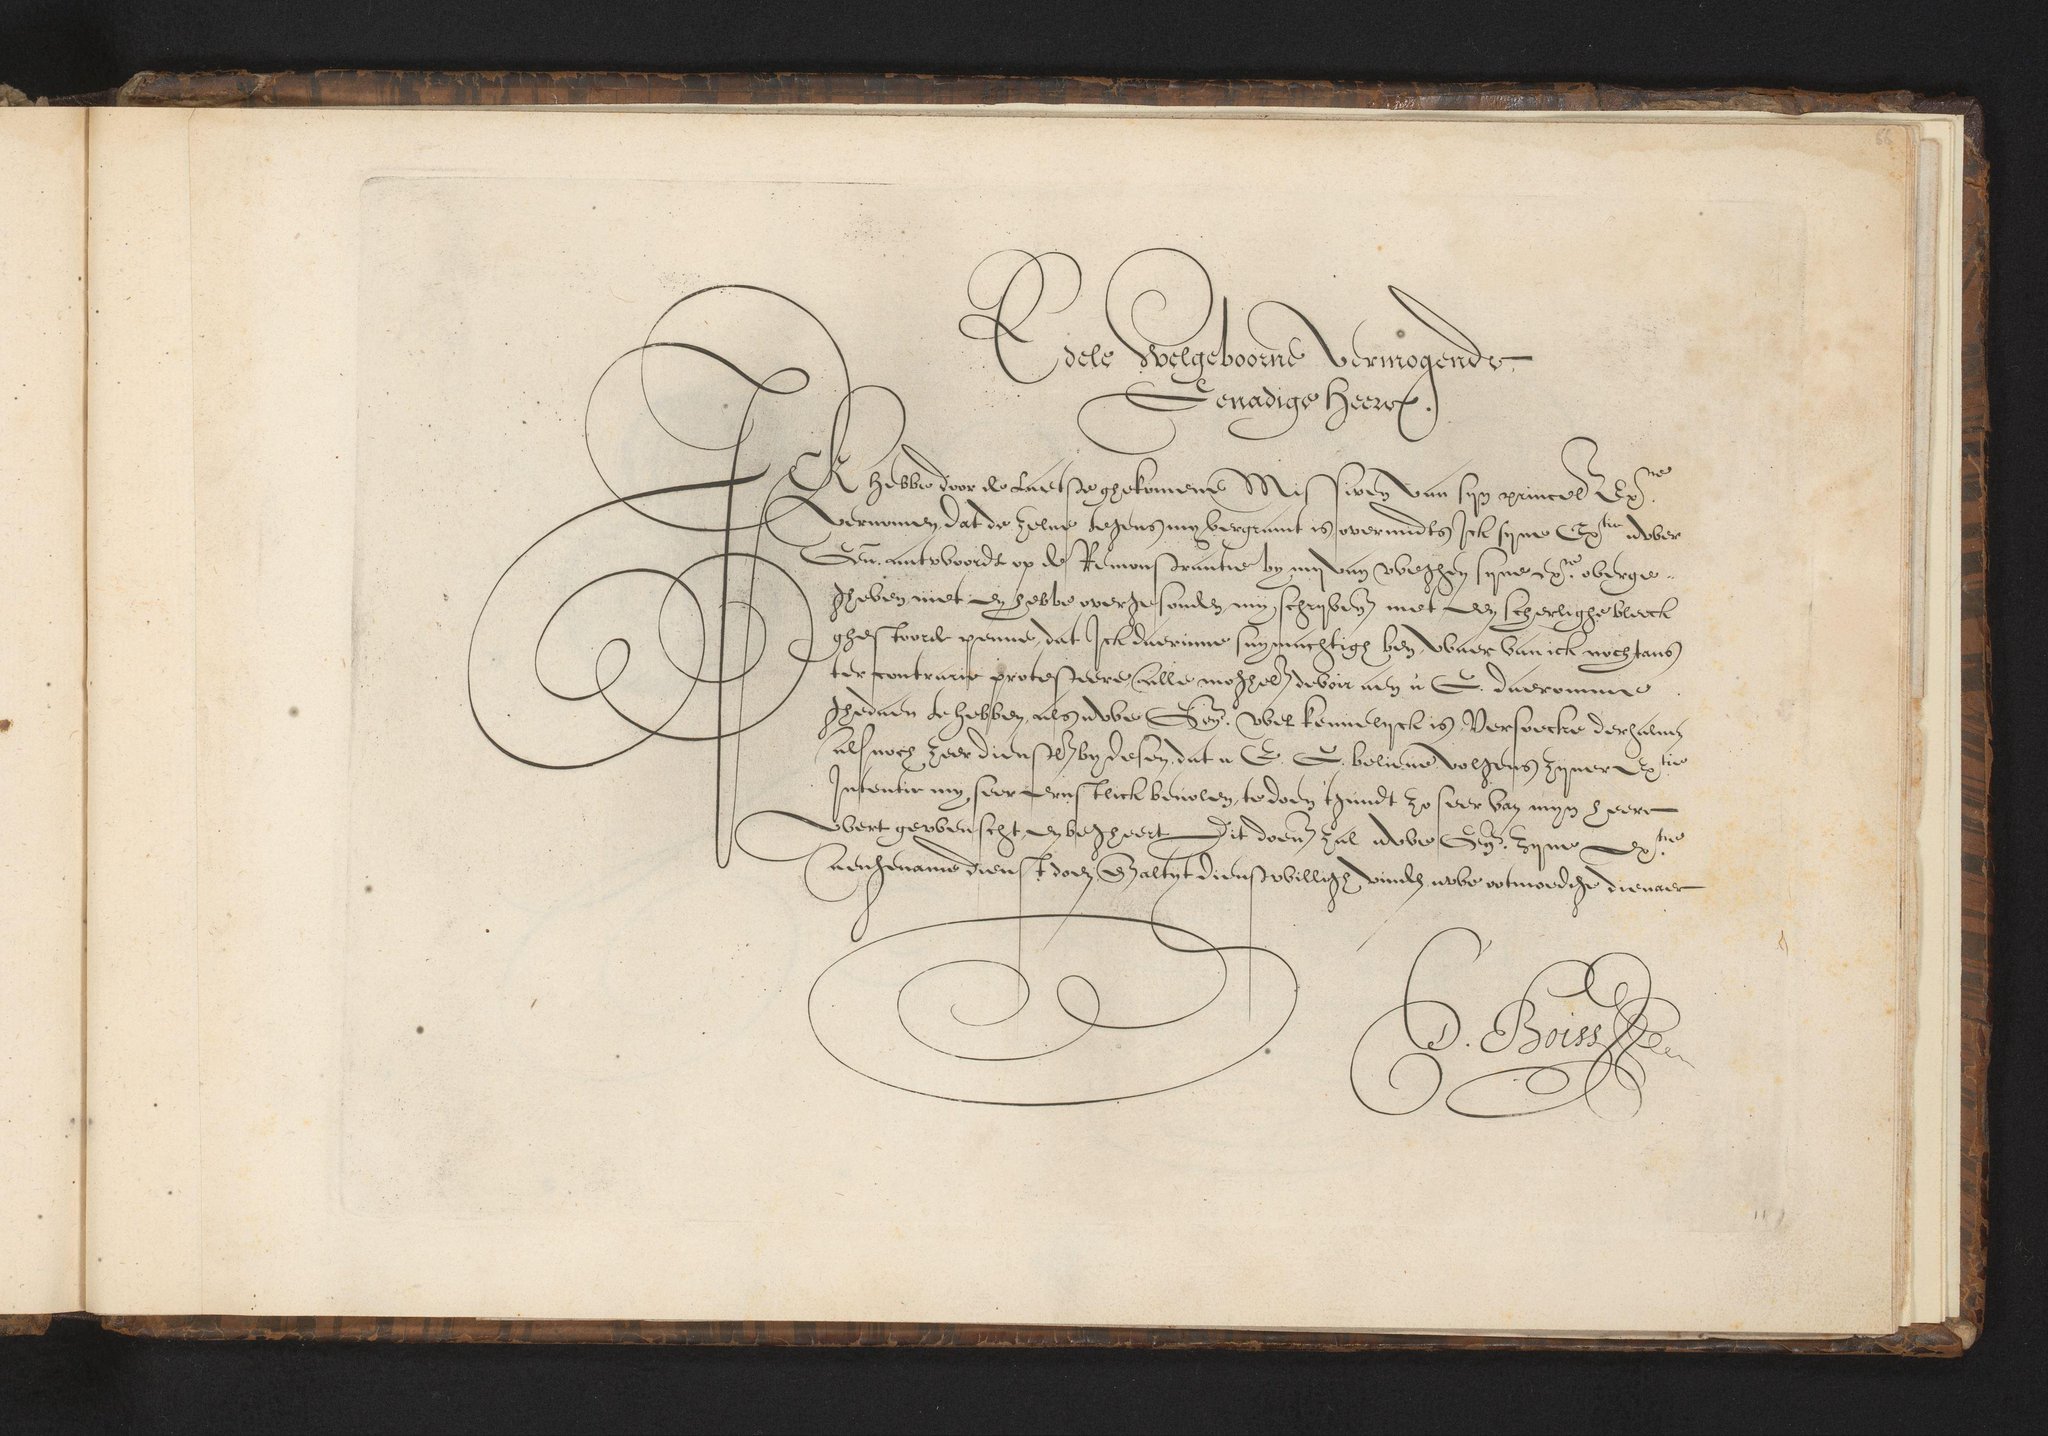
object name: album leaf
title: Grammato-Graphices. In Quo Varia Scripurae Emblemata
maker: cornelis dircksz. boissens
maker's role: draughtsman, print maker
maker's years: 1567-1635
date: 1605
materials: paper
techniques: engraving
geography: amsterdam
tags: calligraphy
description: Schrijfvoorbeeld met elf regels tekst in het Nederlands: Ick hebbe door de laetste ... Daarboven de aanhef: Edele welgeboorne vermogende Genadige Heere. De prent maakt deel uit van een album.